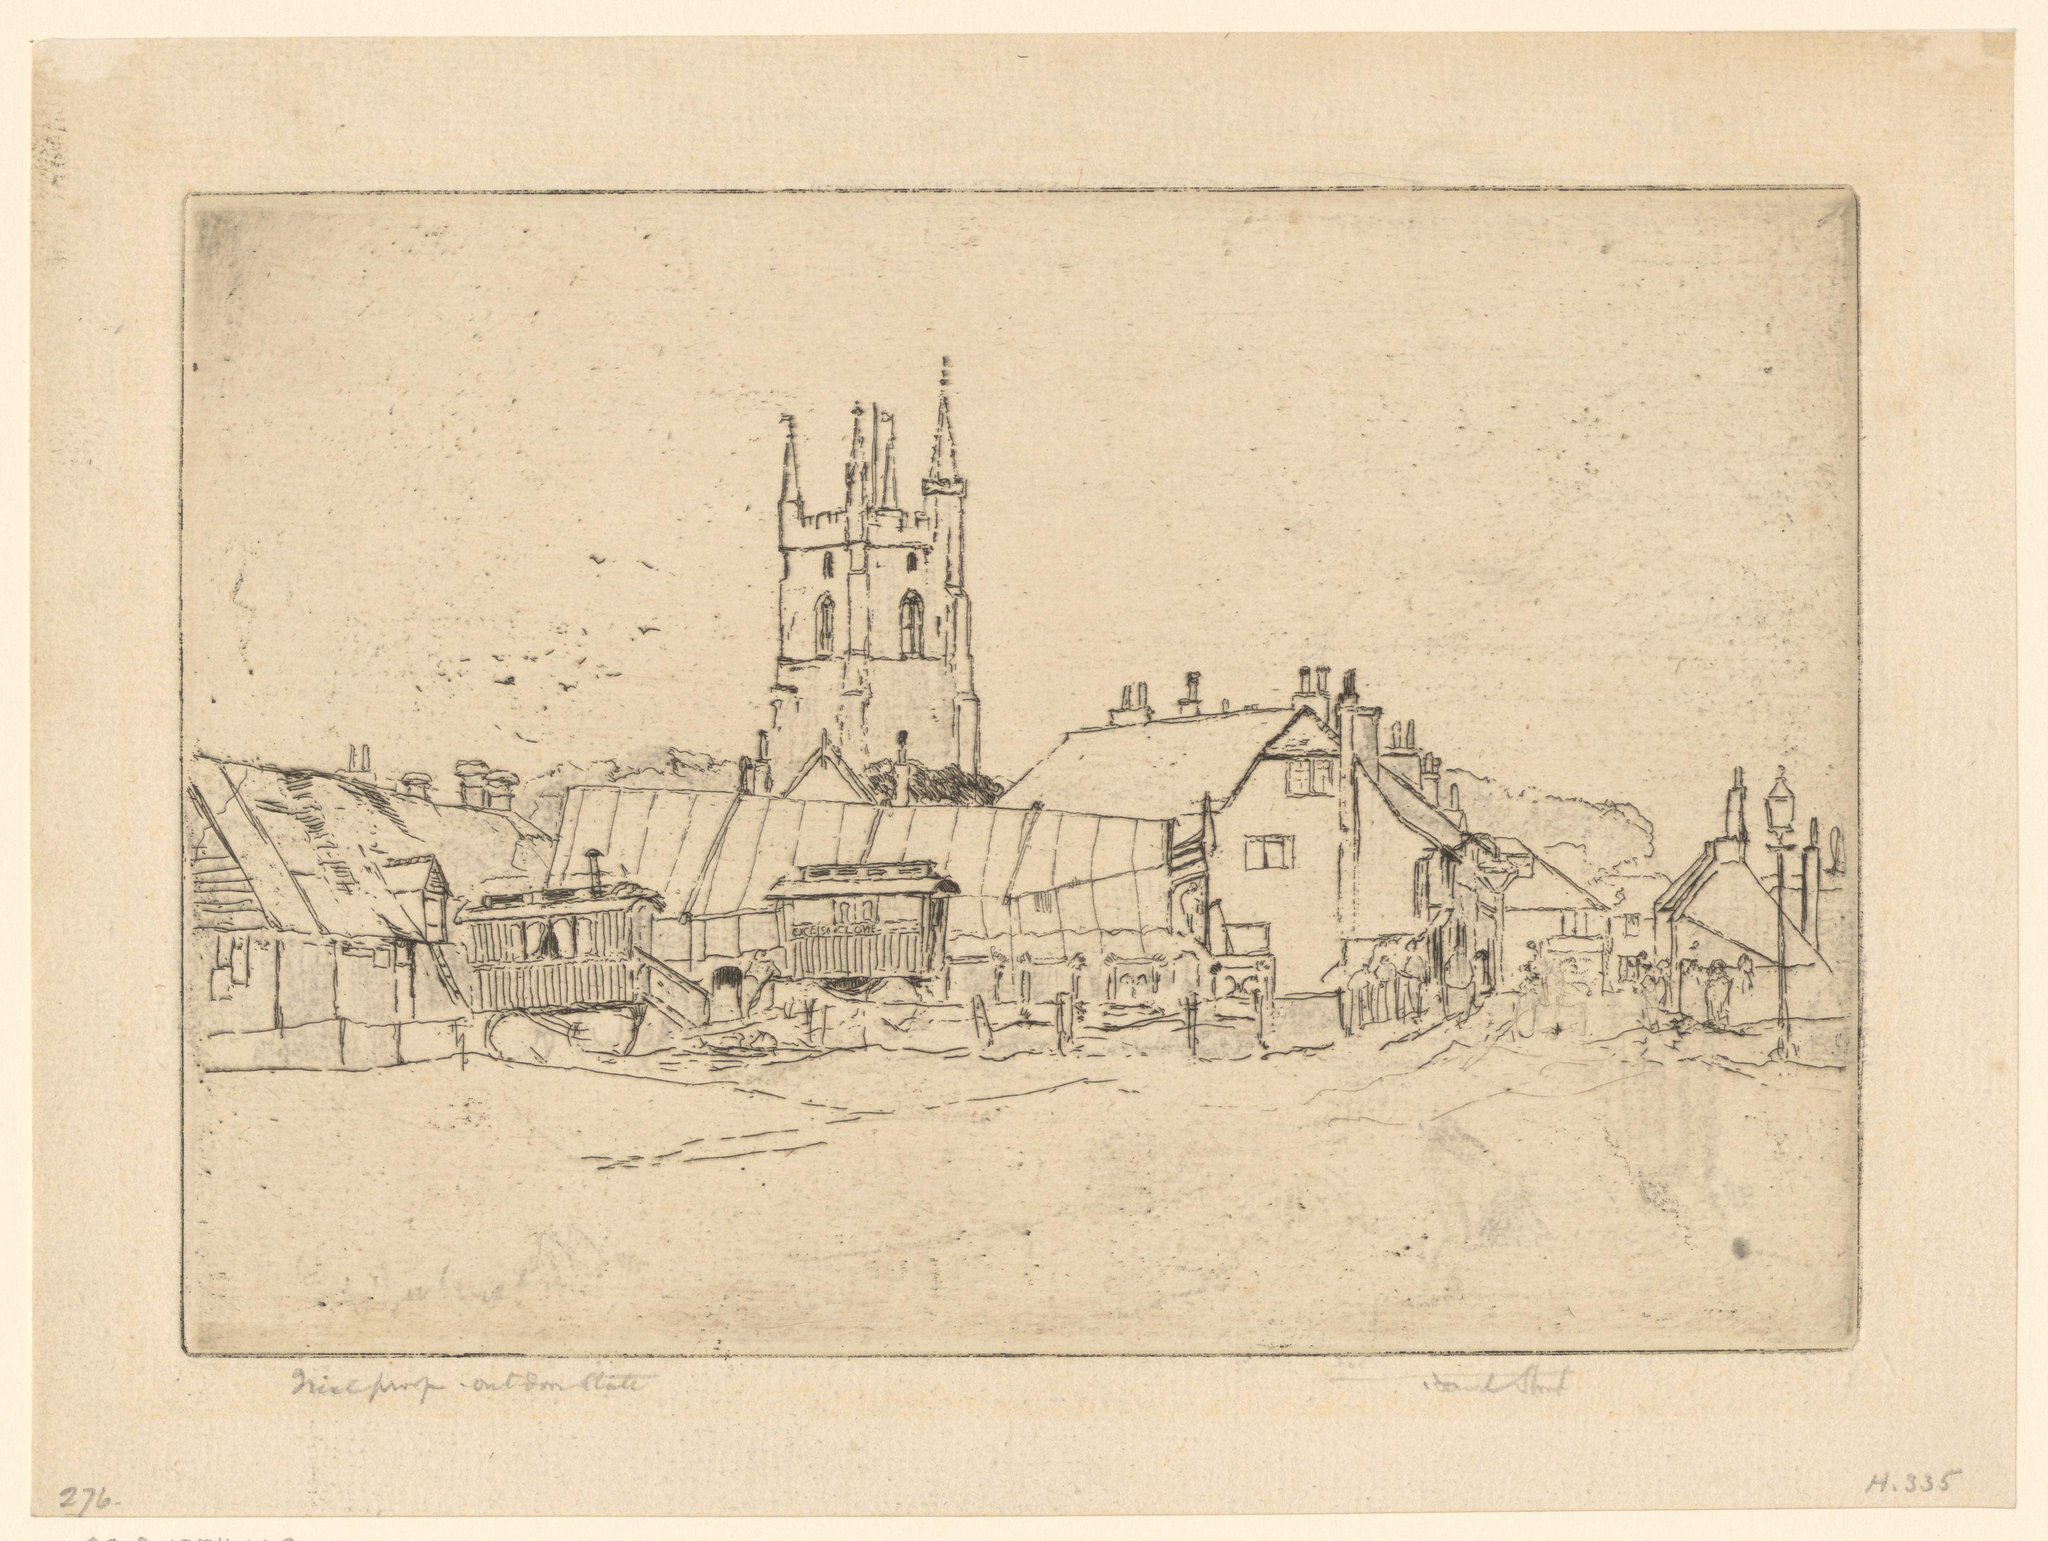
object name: print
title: Gezicht op Lydd met de All Saints Church en twee huifkarren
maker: frank short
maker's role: print maker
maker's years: 1857-1945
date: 1907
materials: paper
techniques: etching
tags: troupe (actors) 'en route', wandering communities living in house-wagons, church (exterior)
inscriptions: inscription: ‘trial proof - outdoor state’, collector's mark: Lugt 2228, signature: ‘Frank Short’, collector's mark: Lugt 2760